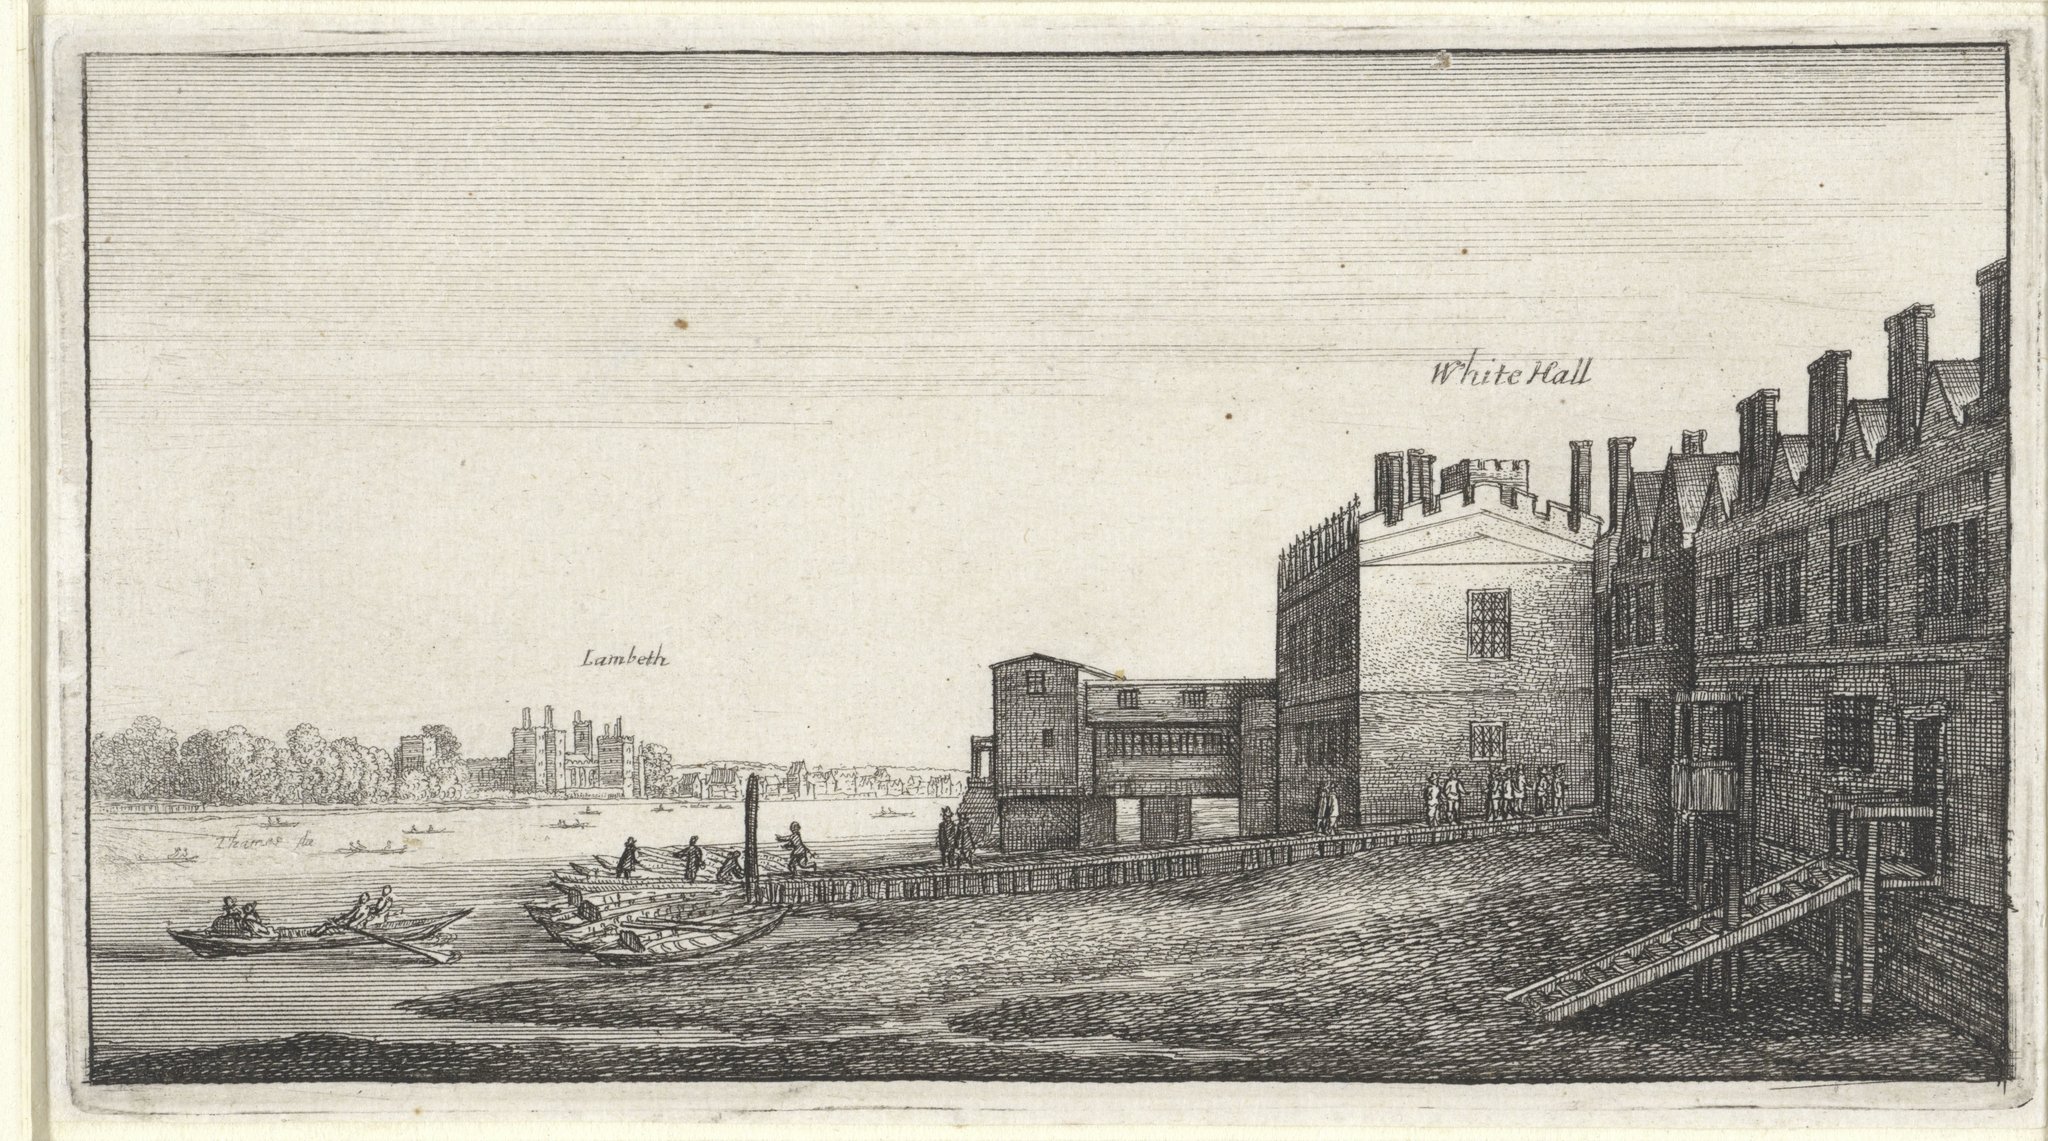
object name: print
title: Amoenissimi Aliquot Locorum in Diversis Provincijs Iacetium Prospectus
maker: wenceslaus hollar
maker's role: draughtsman, print maker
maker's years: 1607-1677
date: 1643-1644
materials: paper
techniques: etching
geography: london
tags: city-view, and landscape with man-made constructions, river, thames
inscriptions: collector's mark: Lugt 240